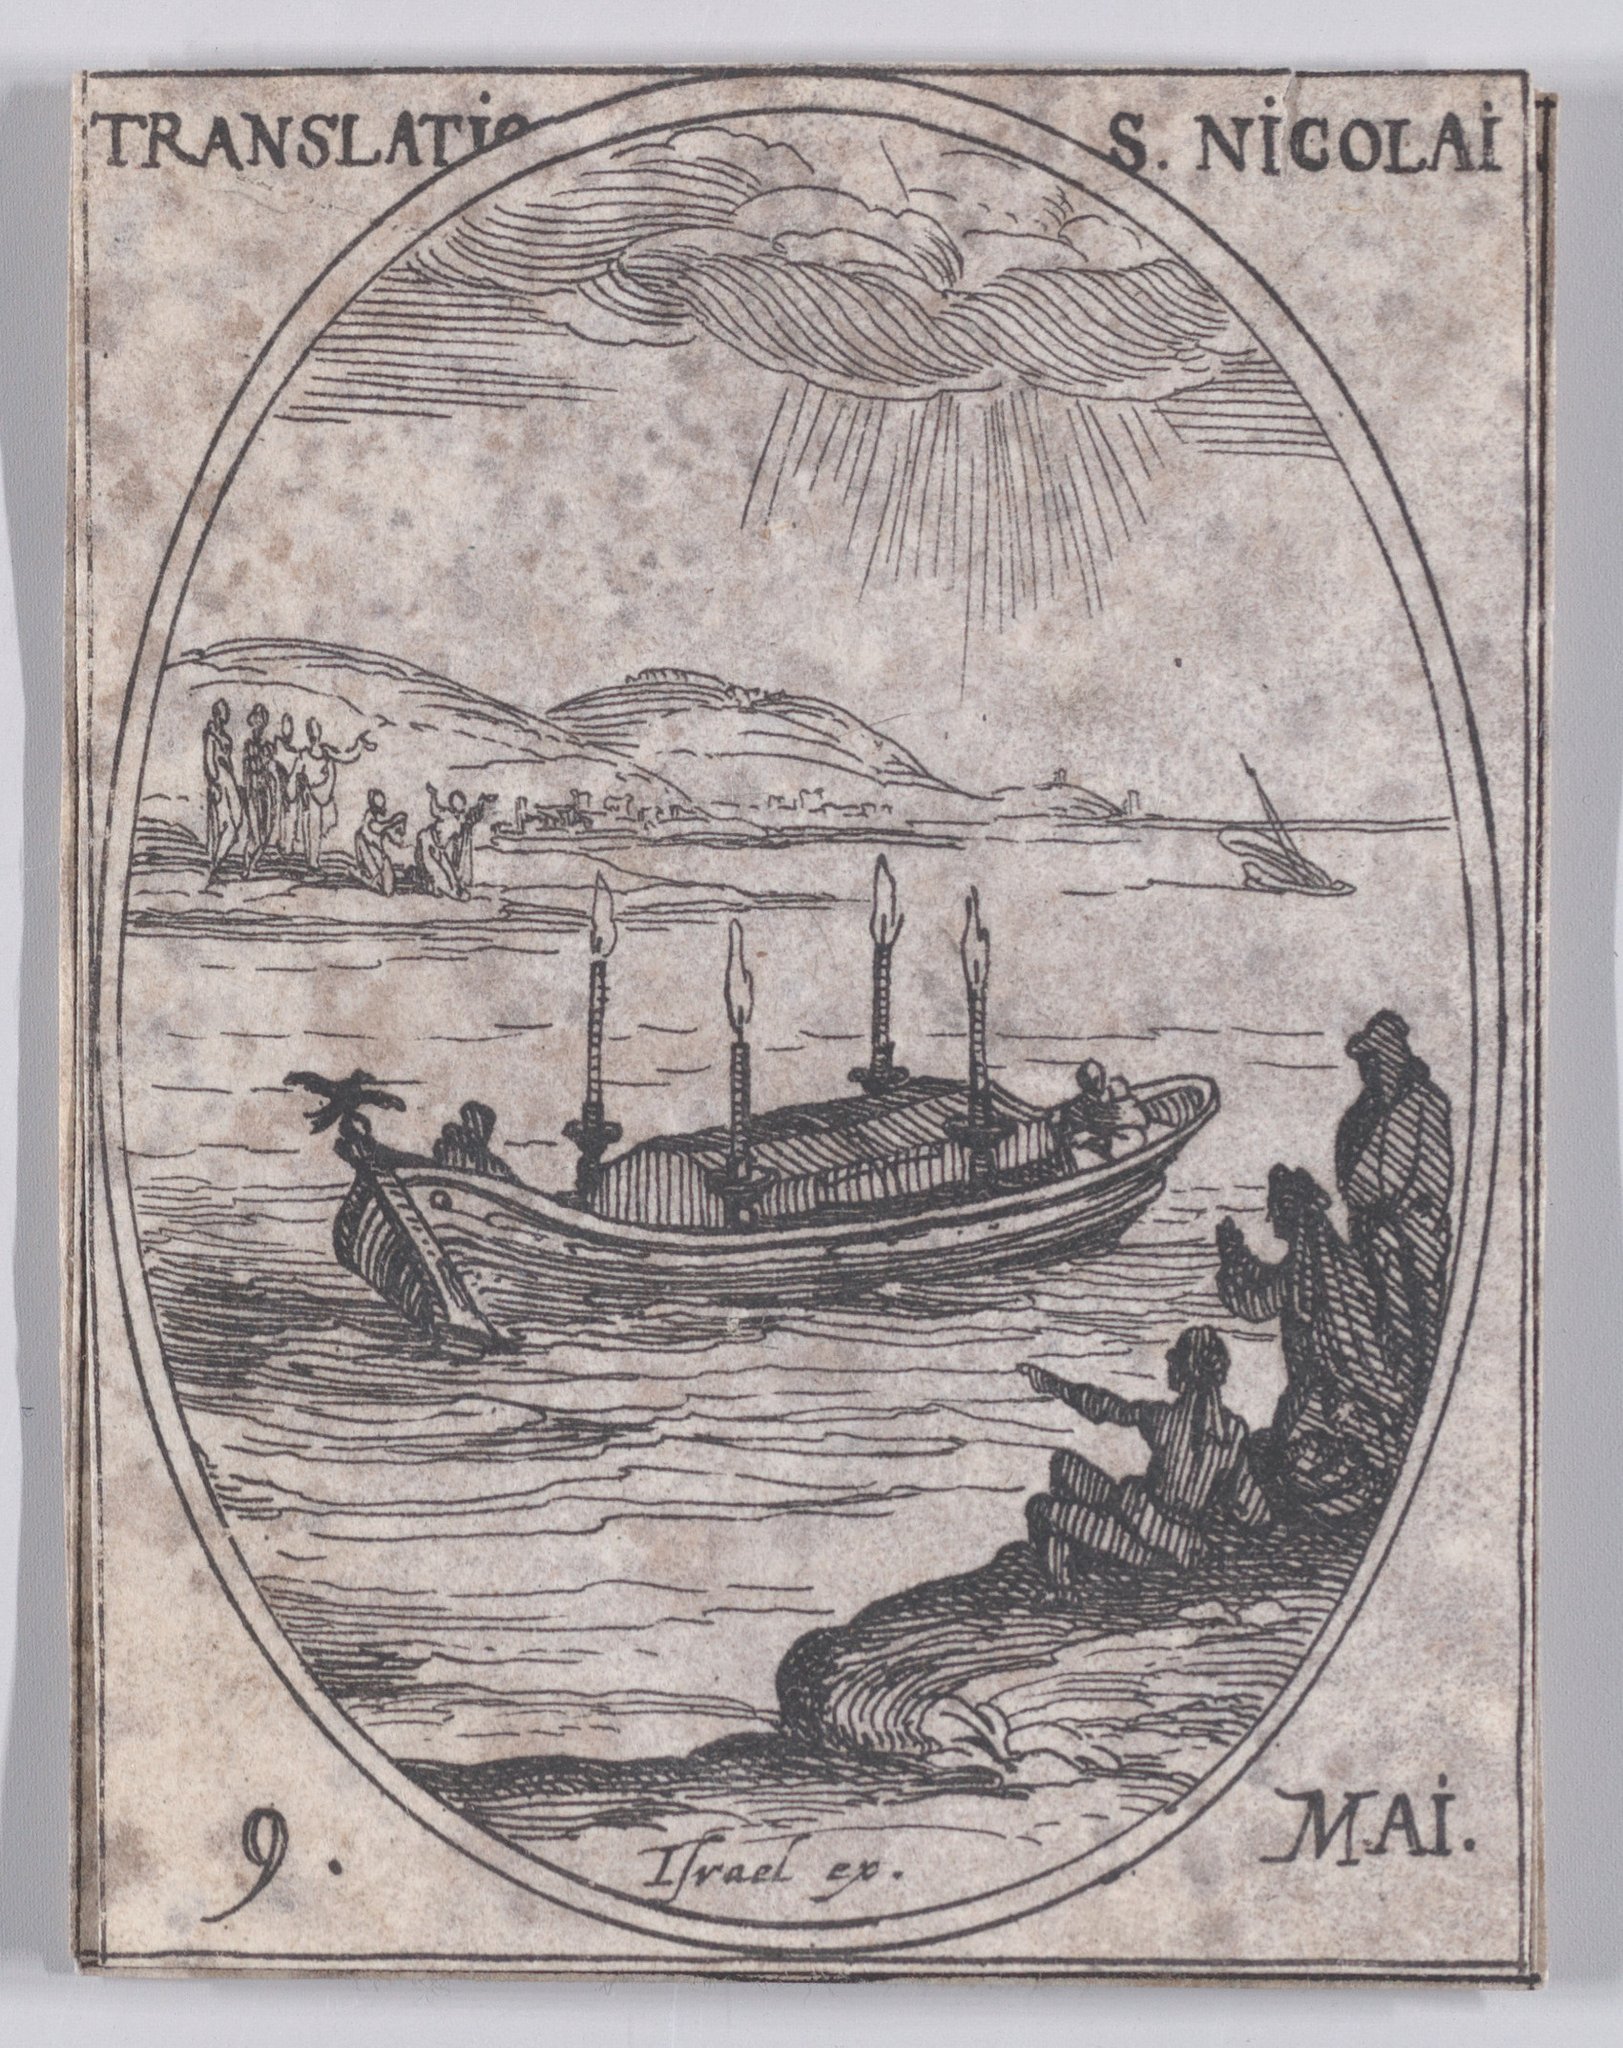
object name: print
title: La Translation de S. Nicolas (The Translation of St. Nicholas), May 9th, from "Les Images De Tous Les Saincts et Saintes de L'Année" (Images of All of the Saints and Religious Events of the Year)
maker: jacques callot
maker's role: artist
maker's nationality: french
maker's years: 1592-1635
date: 1636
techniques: etching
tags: boats